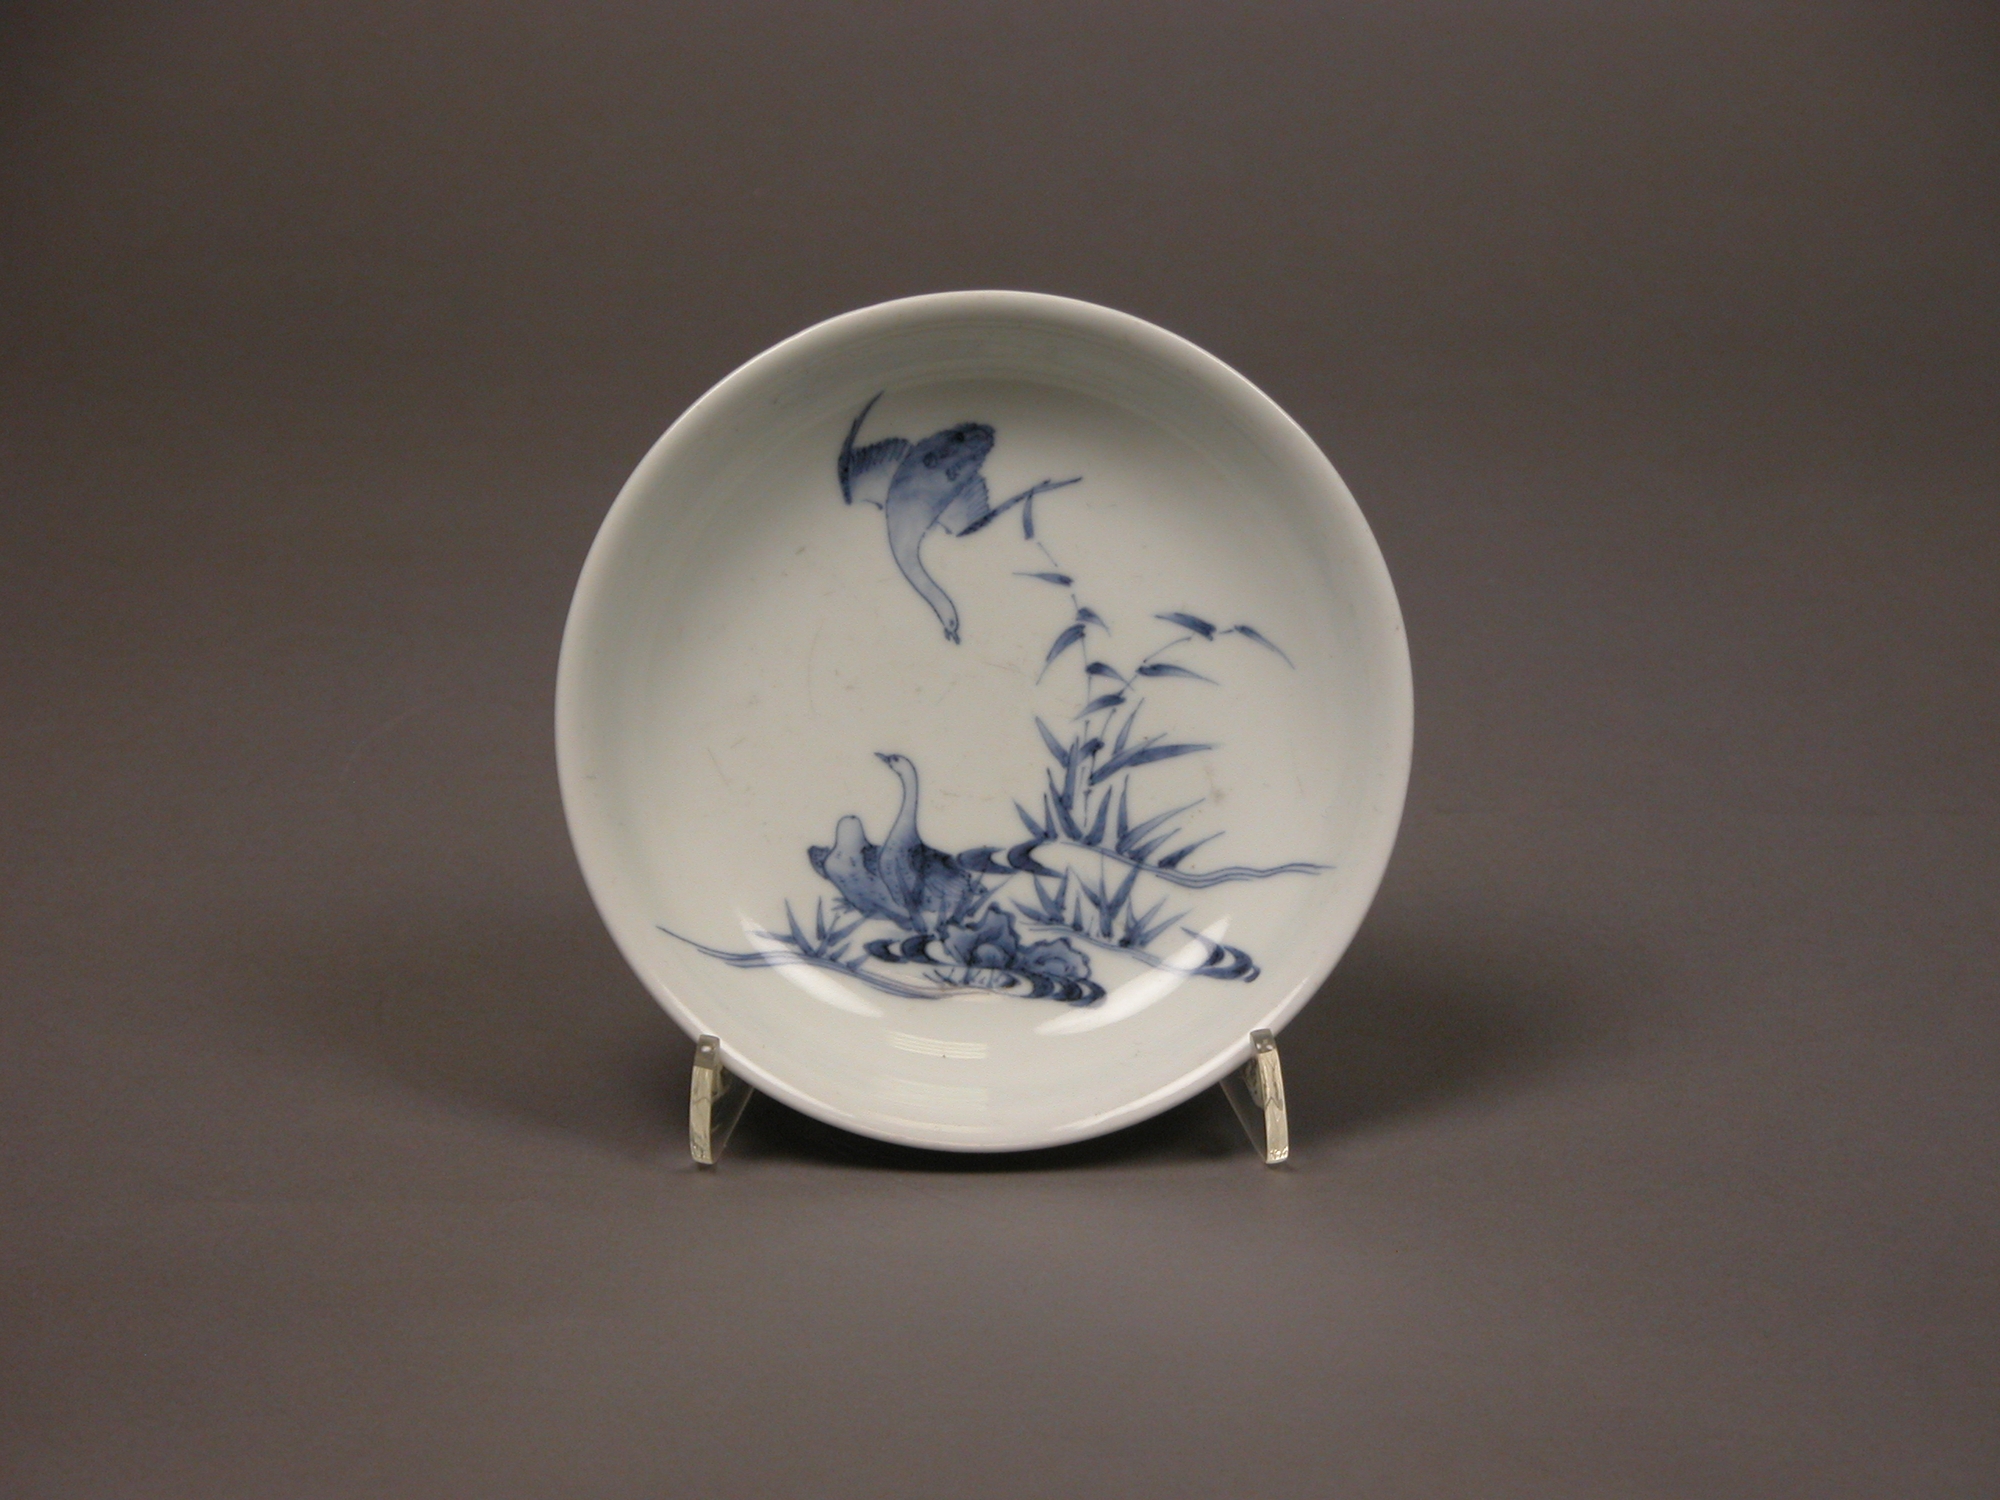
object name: saucer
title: Small Saucer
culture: japanese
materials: glaze, porcelain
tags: birds